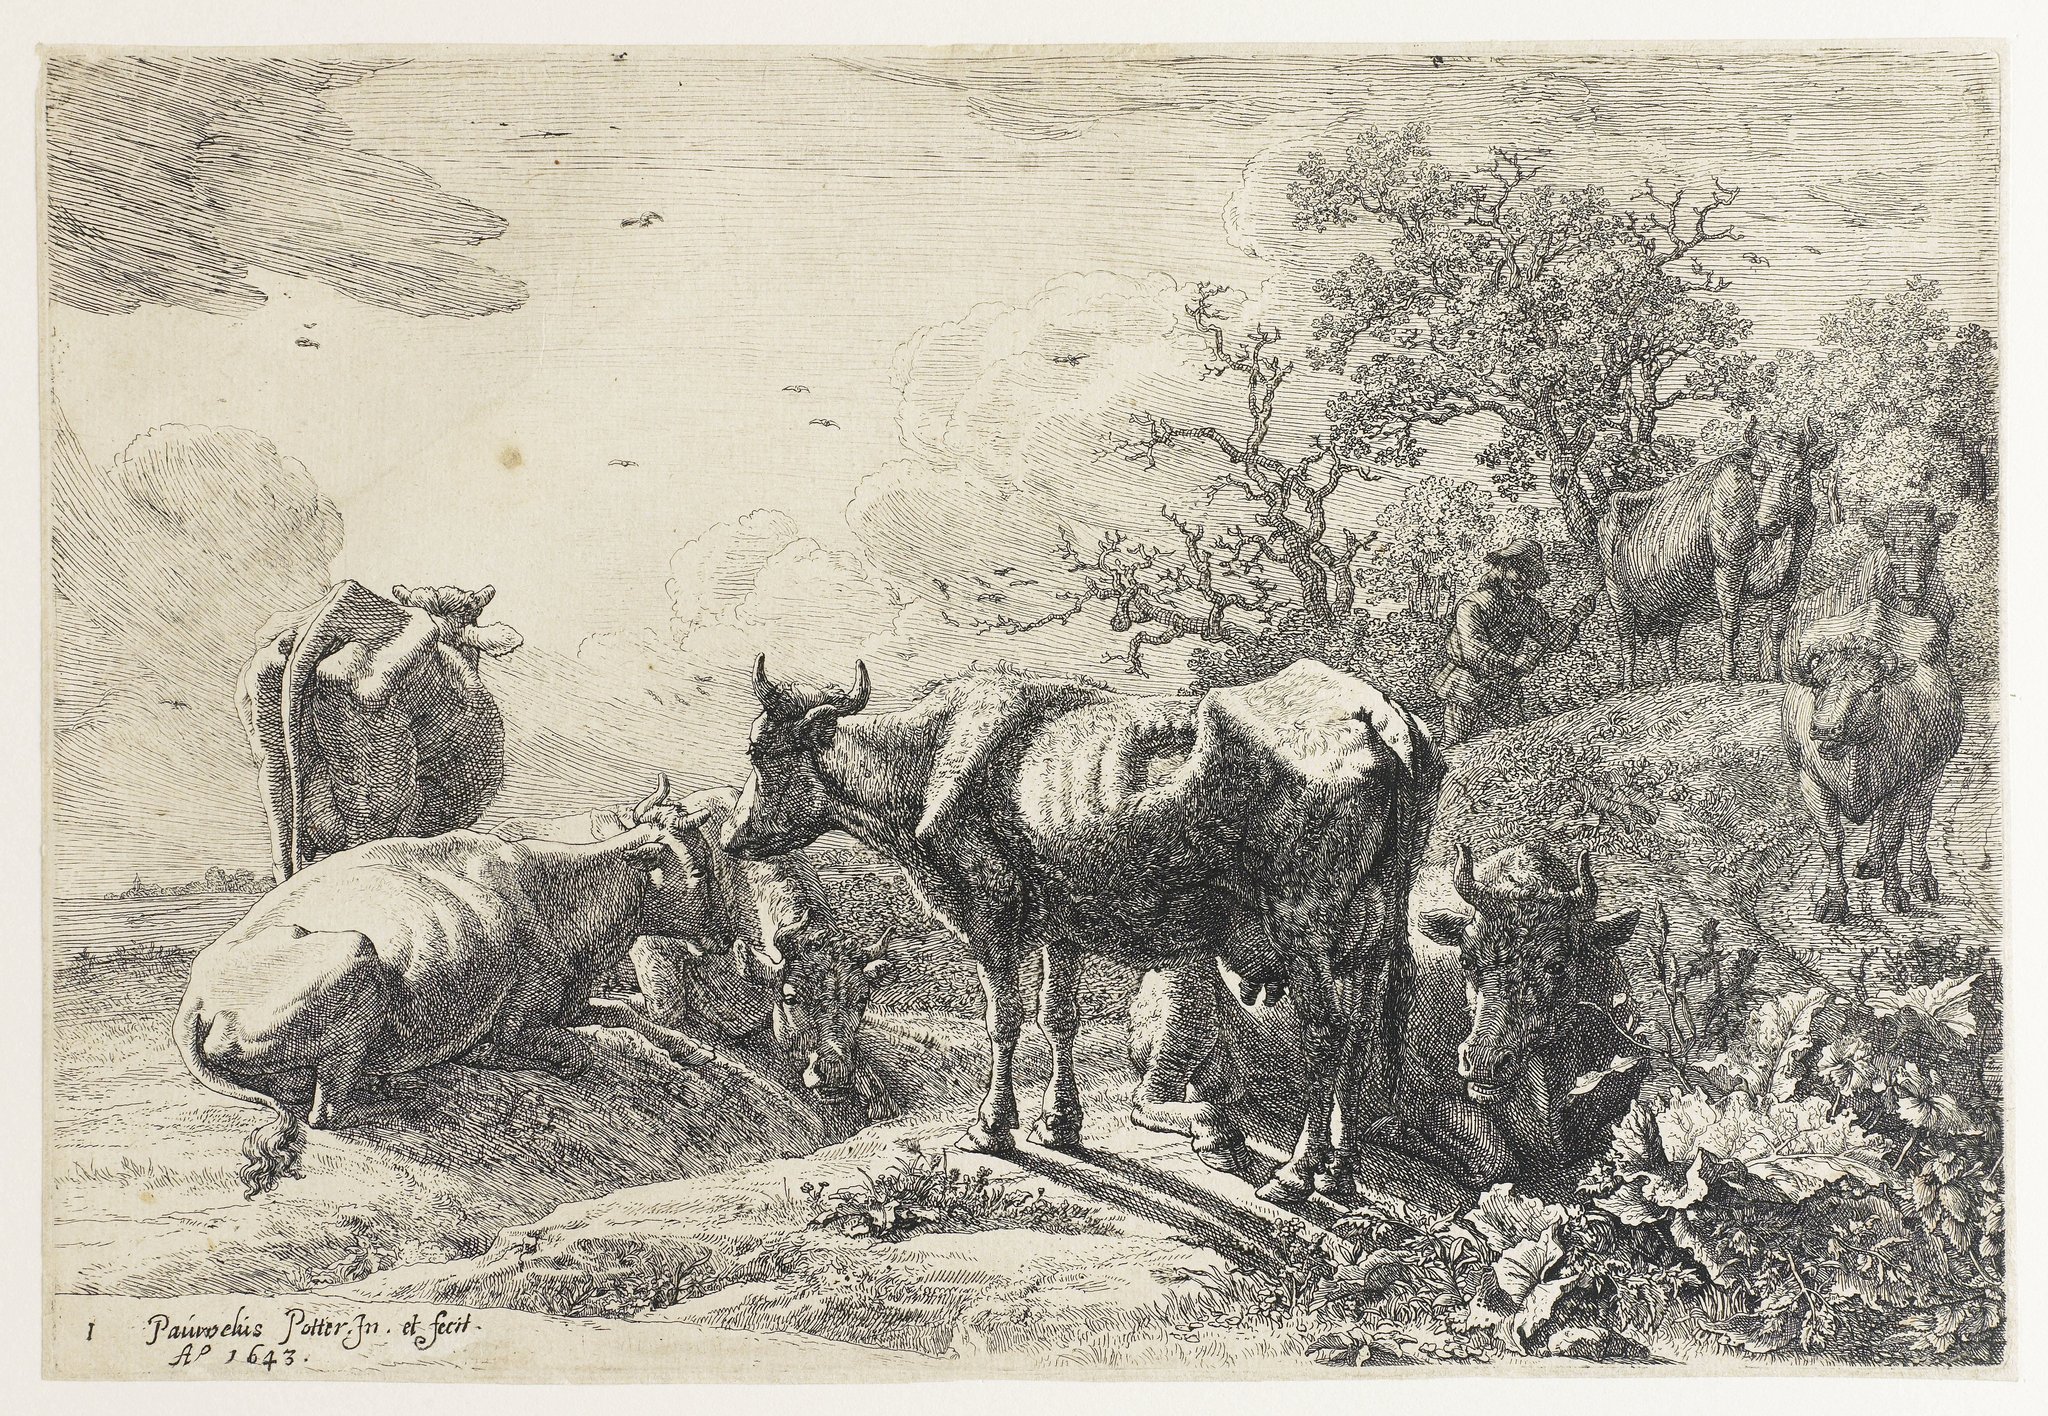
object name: print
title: De veehoeder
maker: paulus potter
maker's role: draughtsman, painter, print maker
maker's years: 1625-1654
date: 1643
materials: paper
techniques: etching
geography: netherlands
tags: herding, herdsman, herdswoman, shepherd, shepherdess, cowherd, etc., bovine cattle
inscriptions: collector's mark: Lugt 240